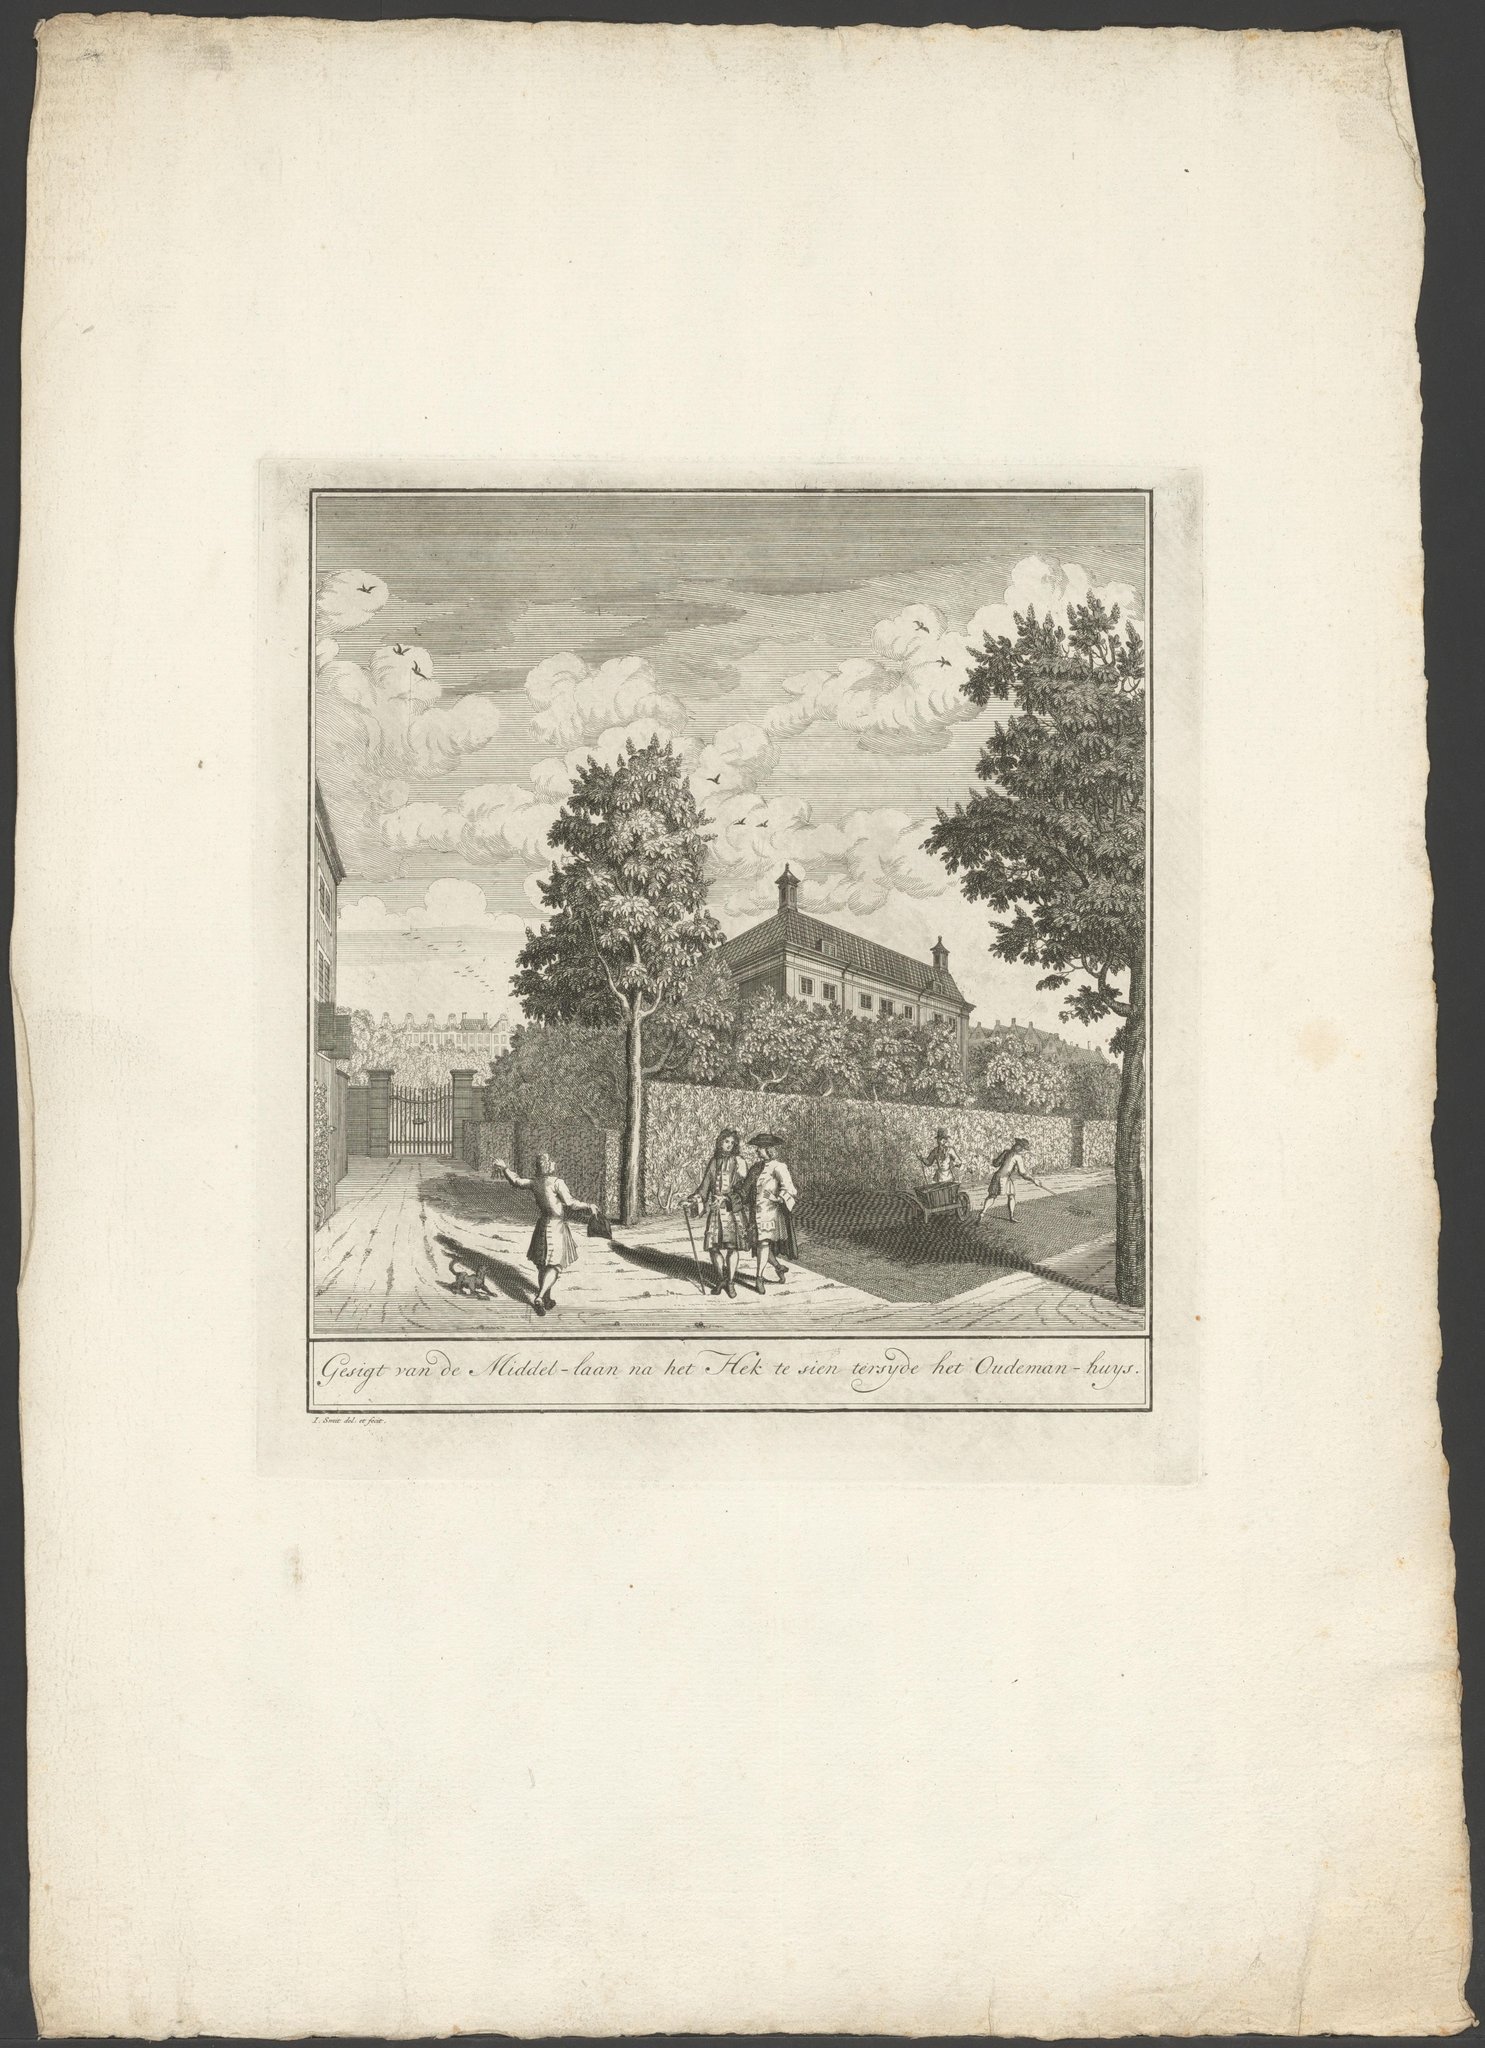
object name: print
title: Gezicht op de achterkant en een deel van de tuin van het Corvershof te Amsterdam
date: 1723-1748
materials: paper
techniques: engraving, etching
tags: alms-house (dutch: 'hofje'), public welfare, key, french or architectonic garden; formal garden, gate, entrance, gardening, dog, old-people's home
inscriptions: collector's mark: ‘ARMWEZEN EN LIEFDADIGHEID’, collector's mark, collector's mark: Lugt 1641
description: Gezicht op de achterkant en een deel van de tuin van het Corvershof aan de Nieuwe Herengracht te Amsterdam. Links op de achtergrond het hek naast het Diaconie Oude Vrouwen- en Mannenhuis aan de Nieuwe Herengracht. Op de voorgrond staat en man met een sleutelbos in zijn hand. Links van hem een hondje, rechts van hem twee wandelende mannen. In het midden van de laan rechts zijn twee tuinmannen aan het werk. Onderdeel van een serie prenten van het in 1723 in gebruik genomen Corvershof, bestemd voor oudere echtparen van Nederduits Gereformeerde (later Hervormde) huize. Onderwerpsrubrieken binnen de Atlas Zeden en Gewoonten: Armwezen en Liefdadigheid.